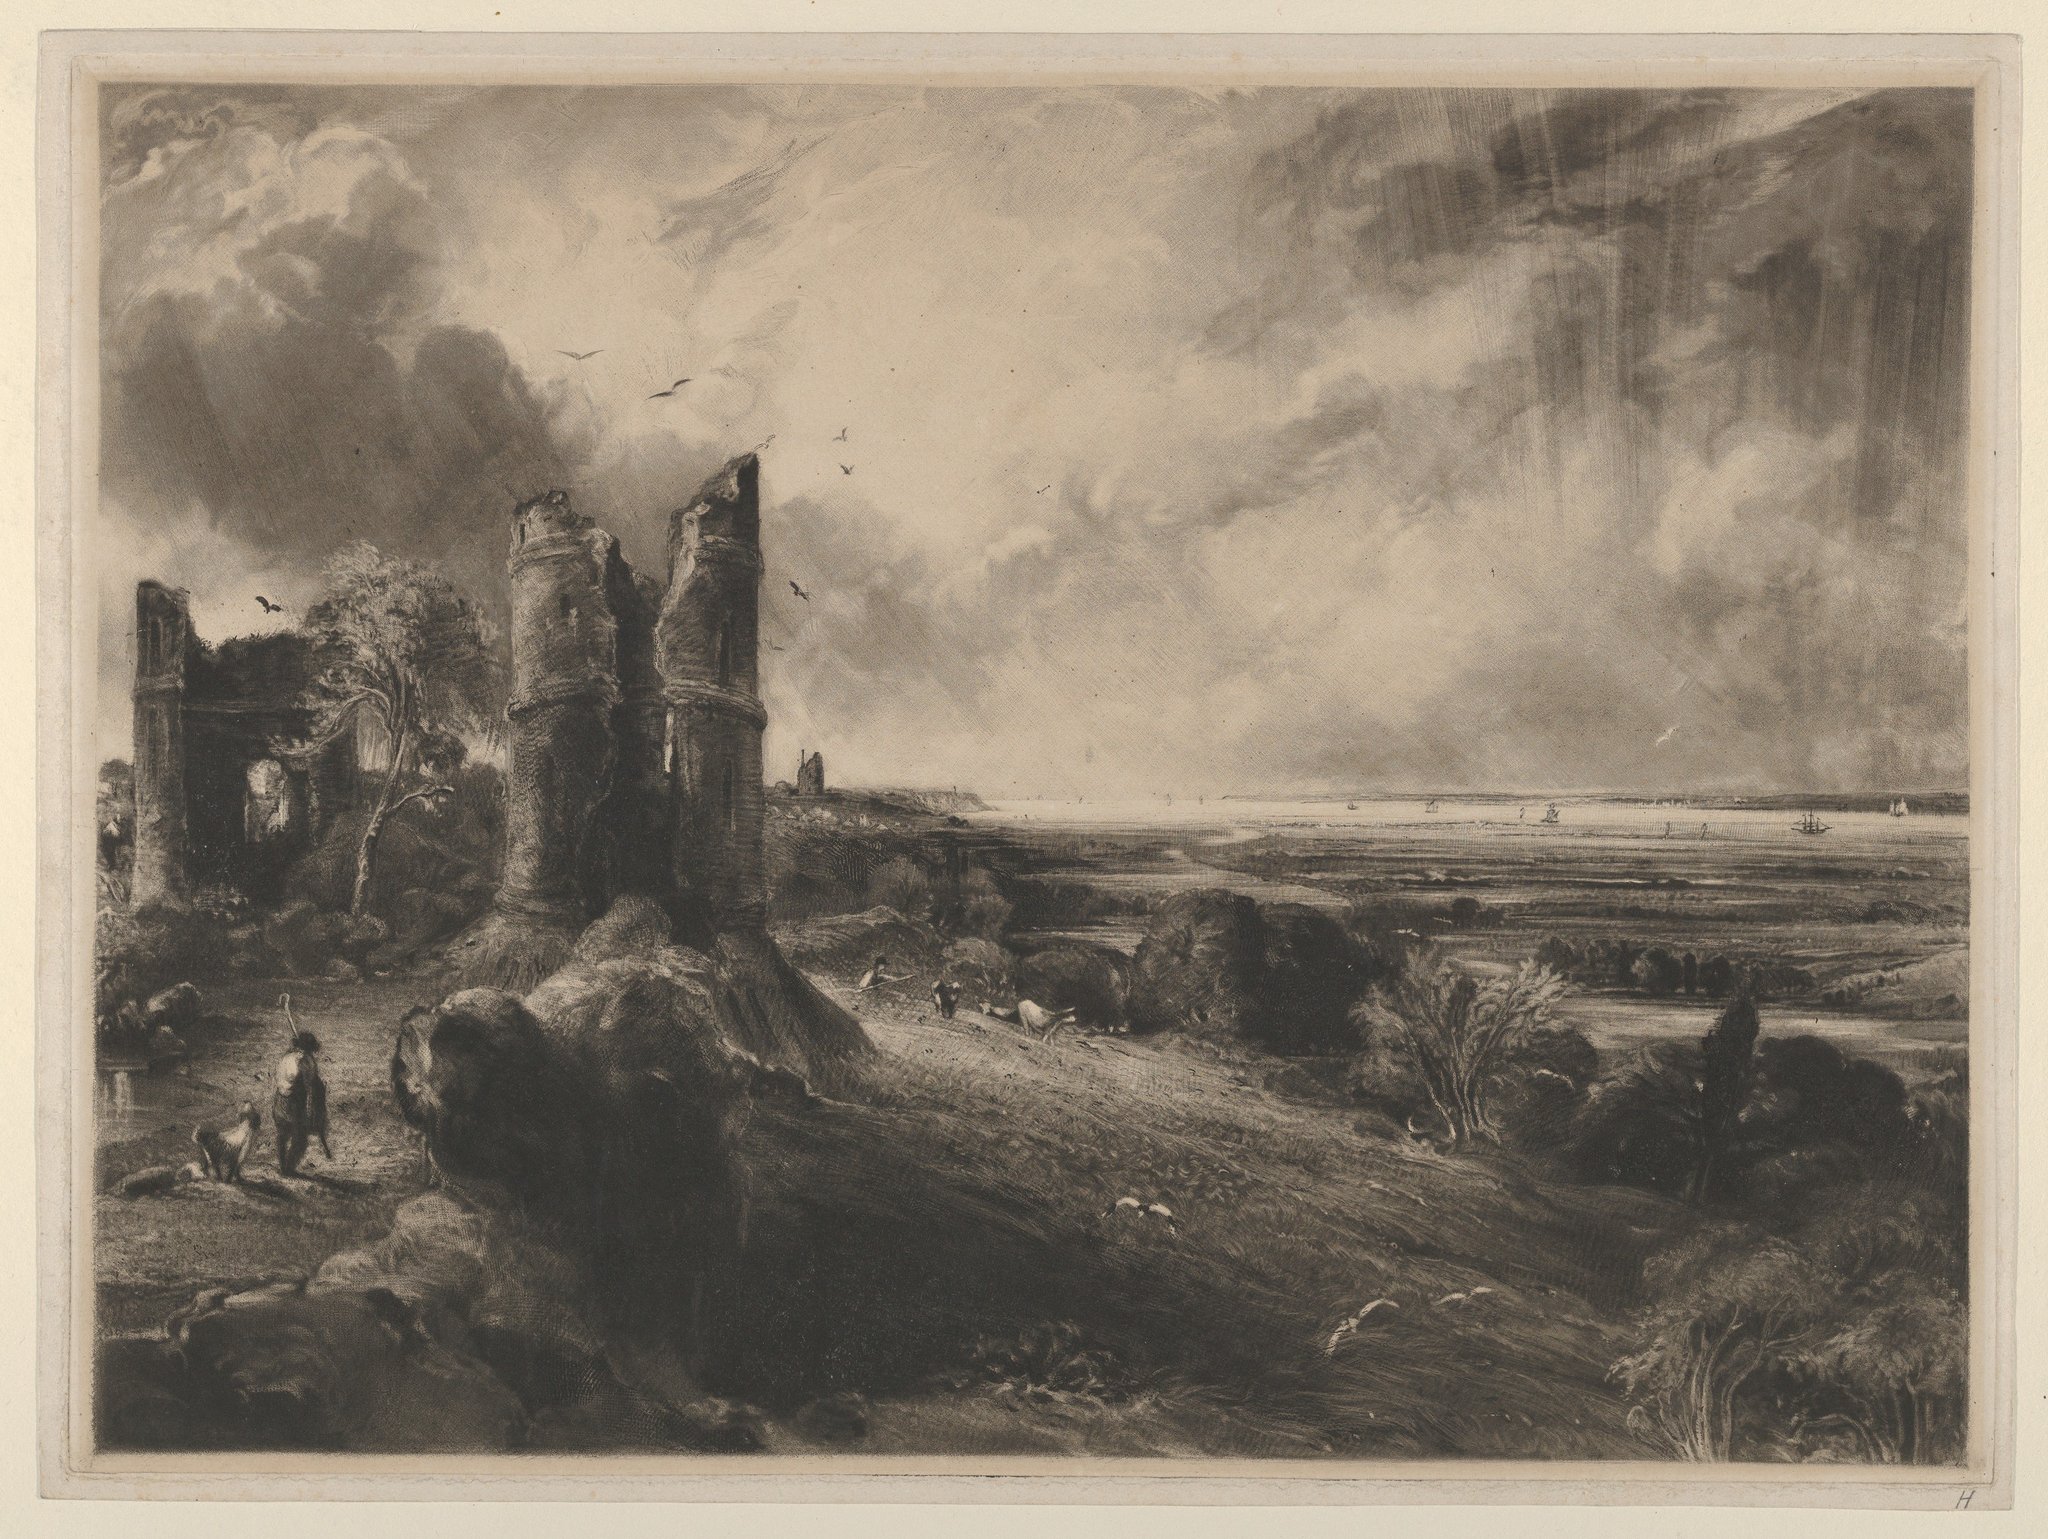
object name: print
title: Hadleigh Castle: Large Plate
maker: david lucas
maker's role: artist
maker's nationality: british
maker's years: 1802-1881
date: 1830-1832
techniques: mezzotint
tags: ruins